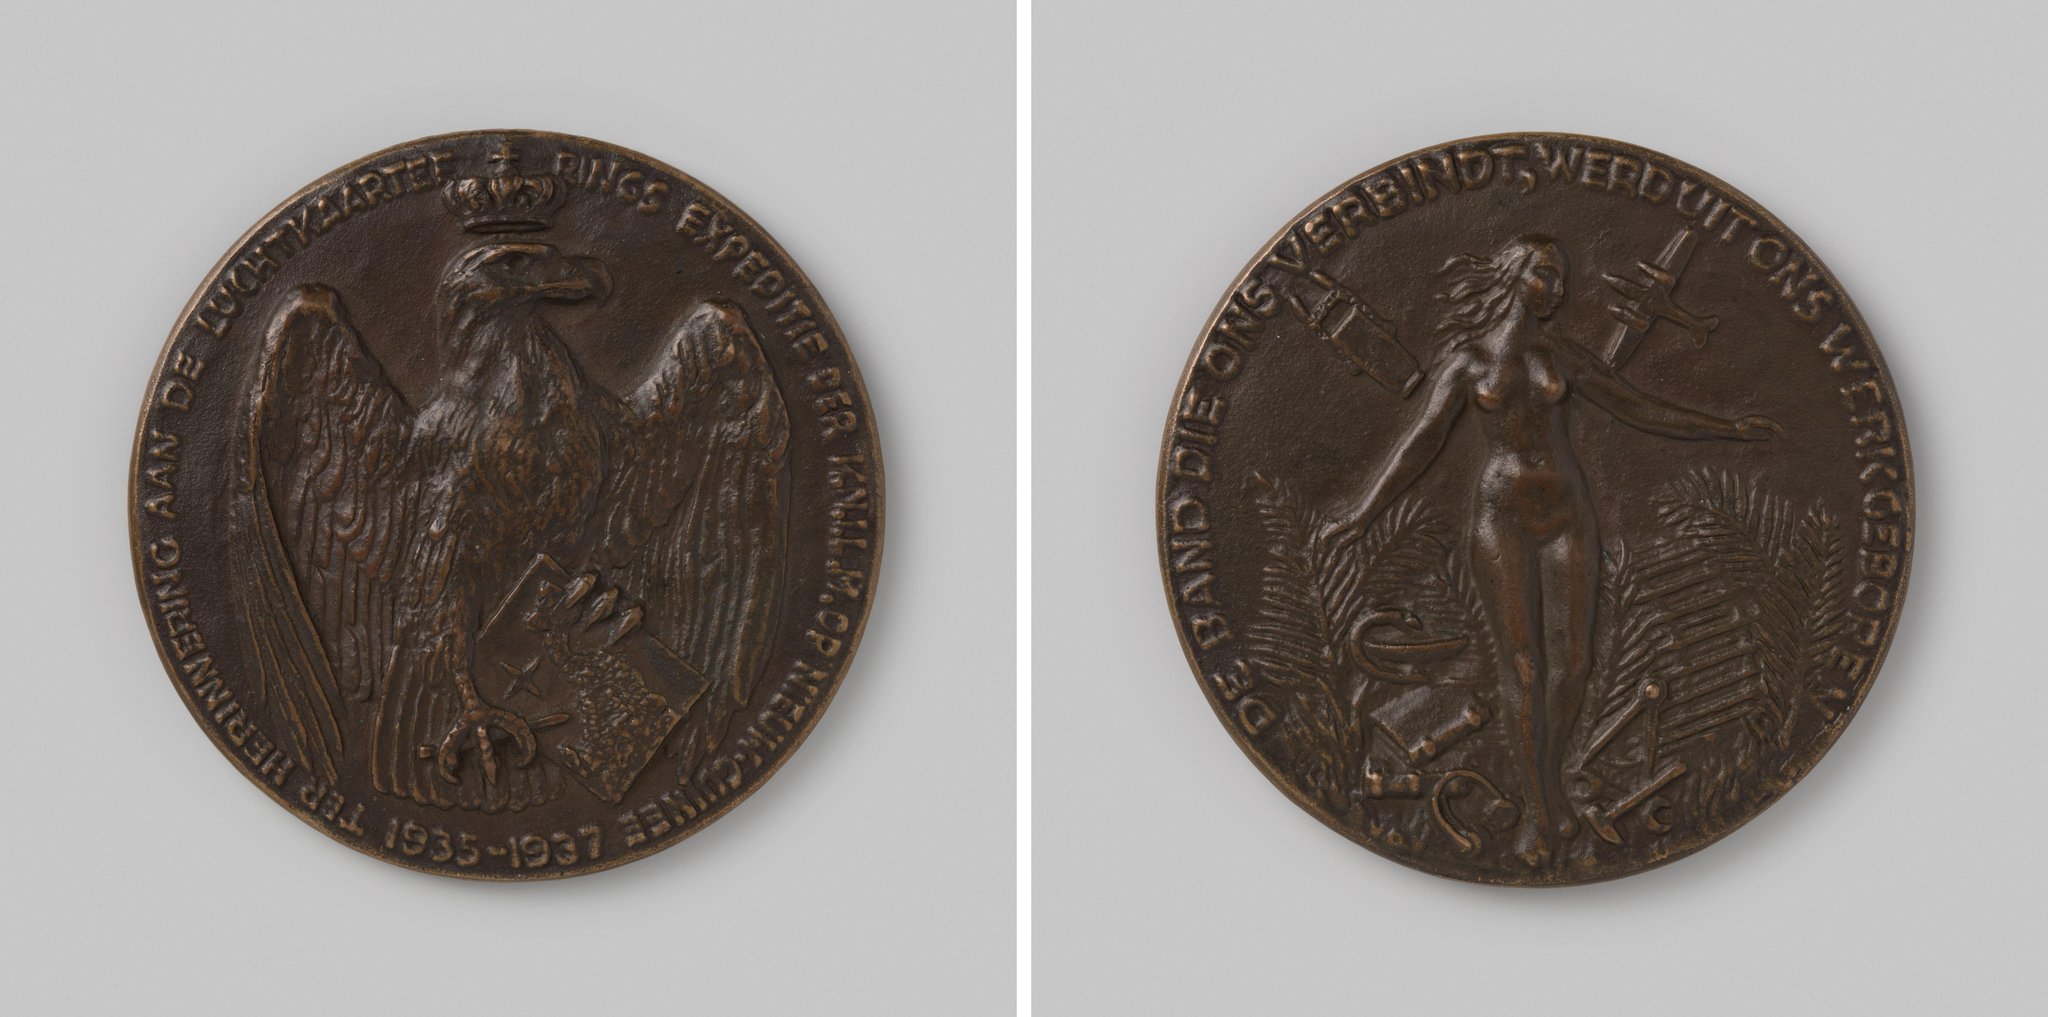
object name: medal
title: Luchtkarteringsexpeditie naar Nederlands Nieuw-Guinea 1935-1937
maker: gerrit jan van der veen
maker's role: sculptor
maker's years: 1902-1944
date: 1938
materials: bronze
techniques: casting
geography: netherlands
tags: nieuw-guinea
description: In zeer kleine oplage vervaardigd; op naam van H. Jacobson, tussen 1928 en 1940 lid van de Raad van Bestuur van de Koninklijke Nederlandsch-Indische Luchtvaart Maatschappij.